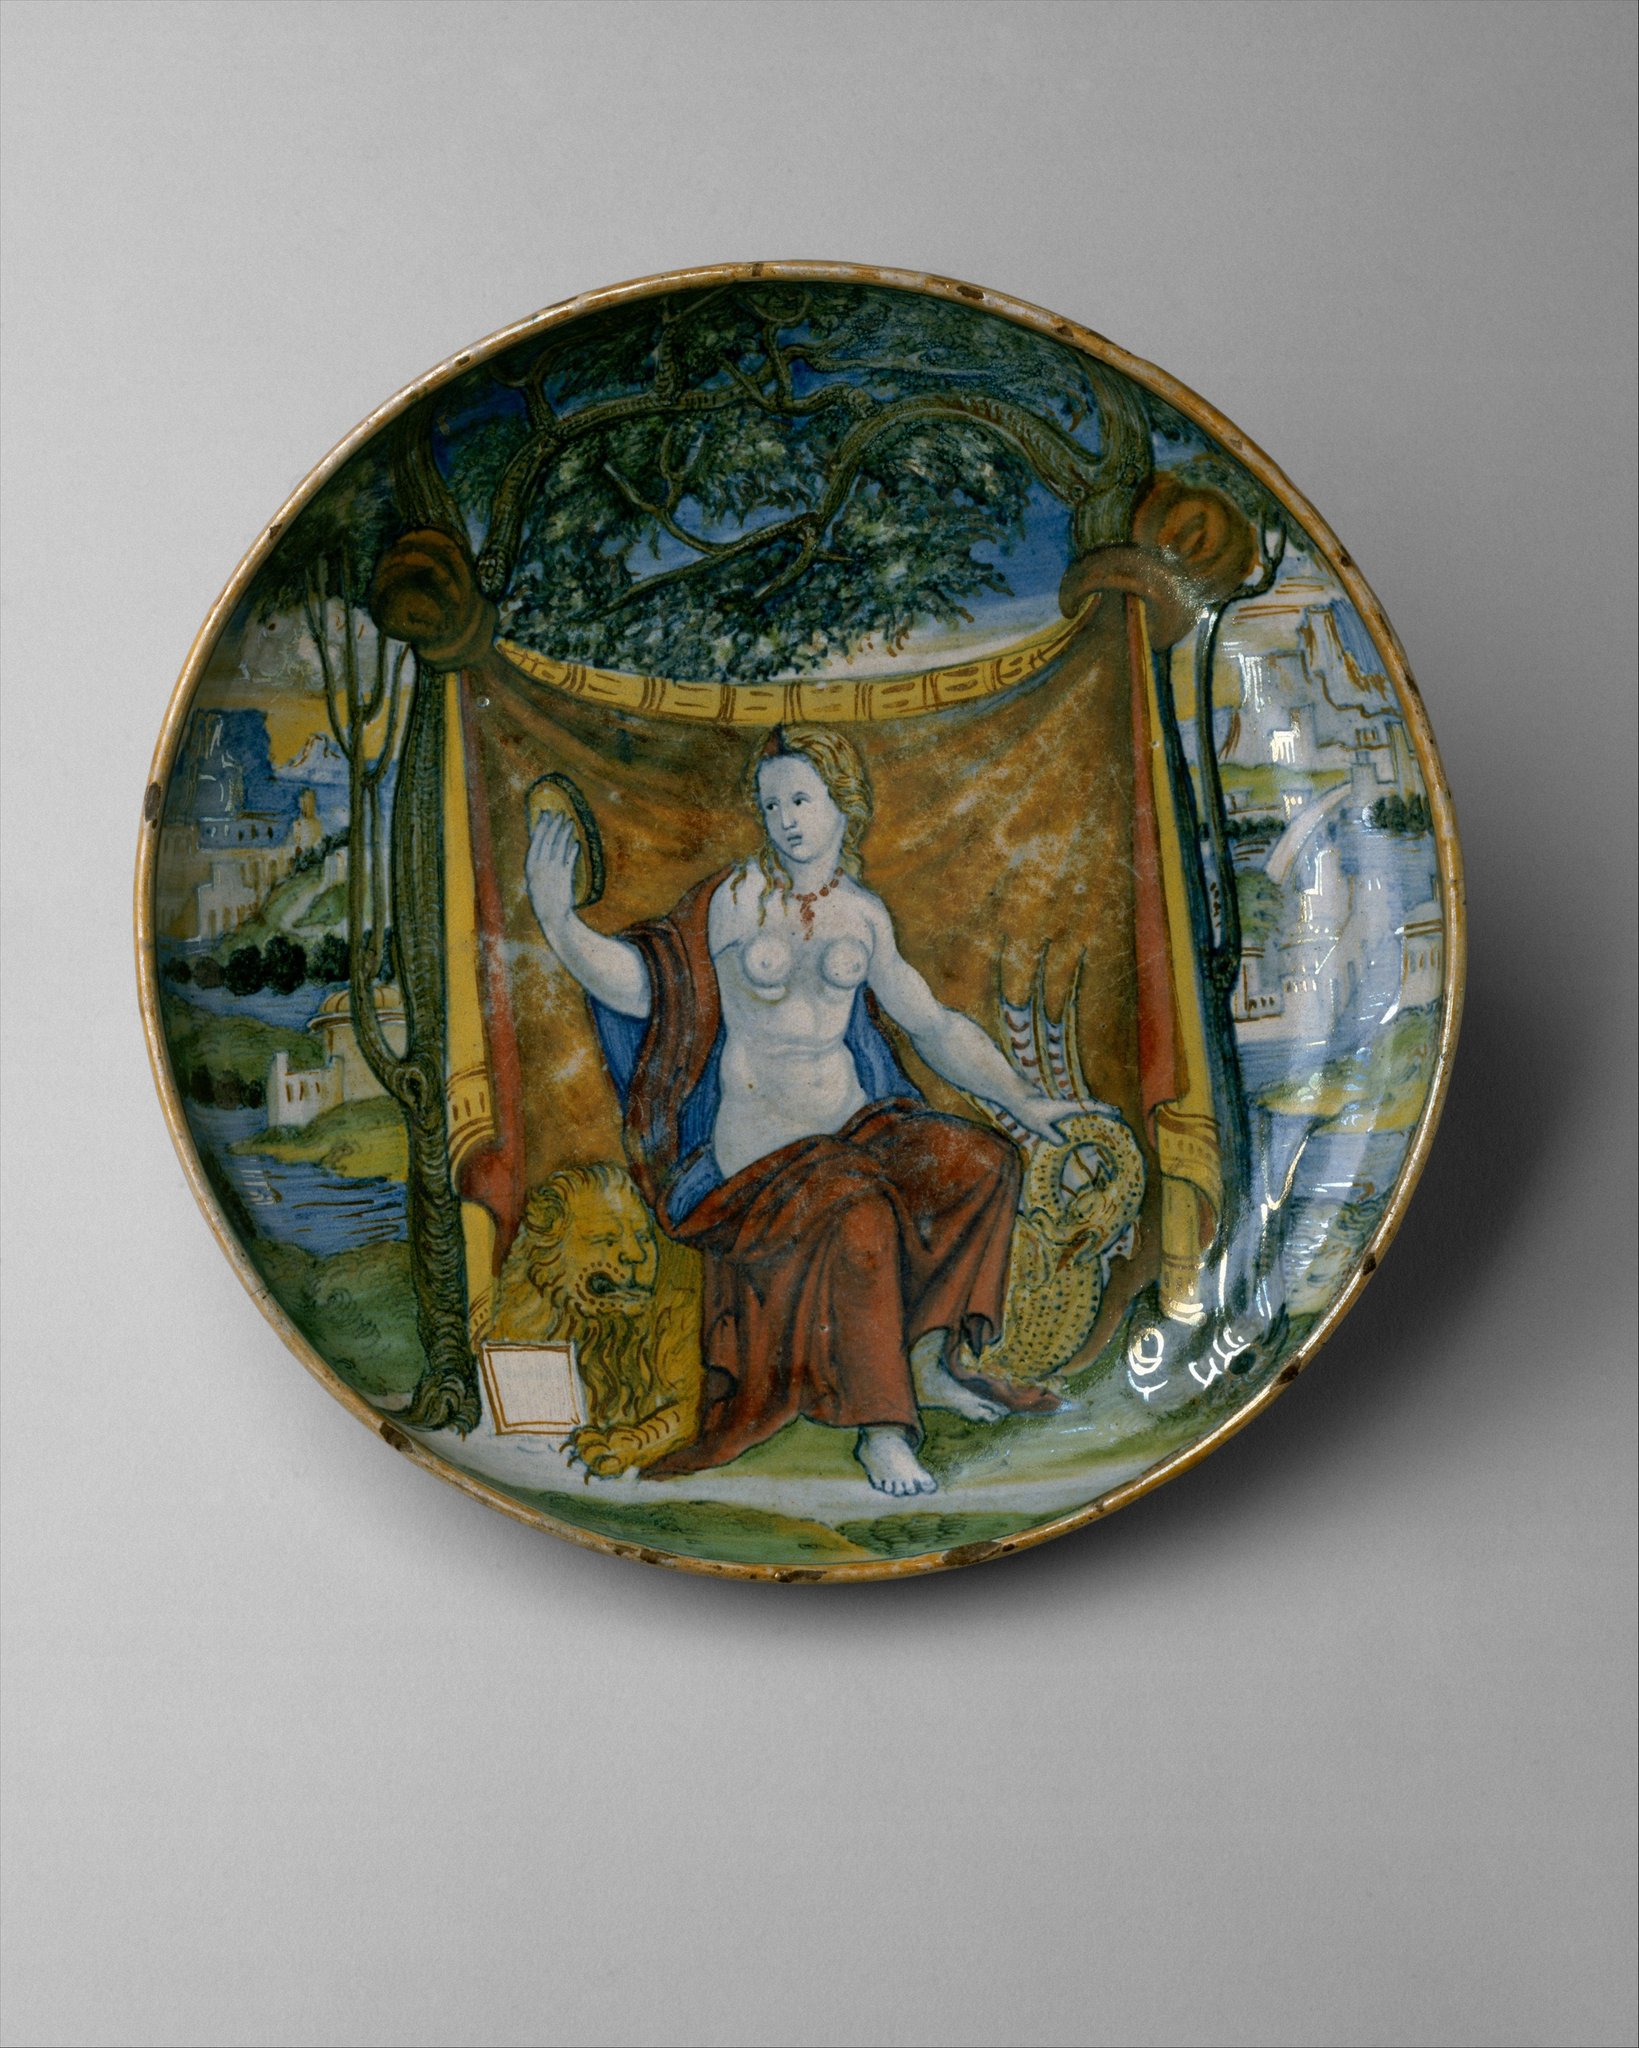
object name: dish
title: Dish (coppa)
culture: italian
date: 1525-1530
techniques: maiolica, glazing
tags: female nudes,lions